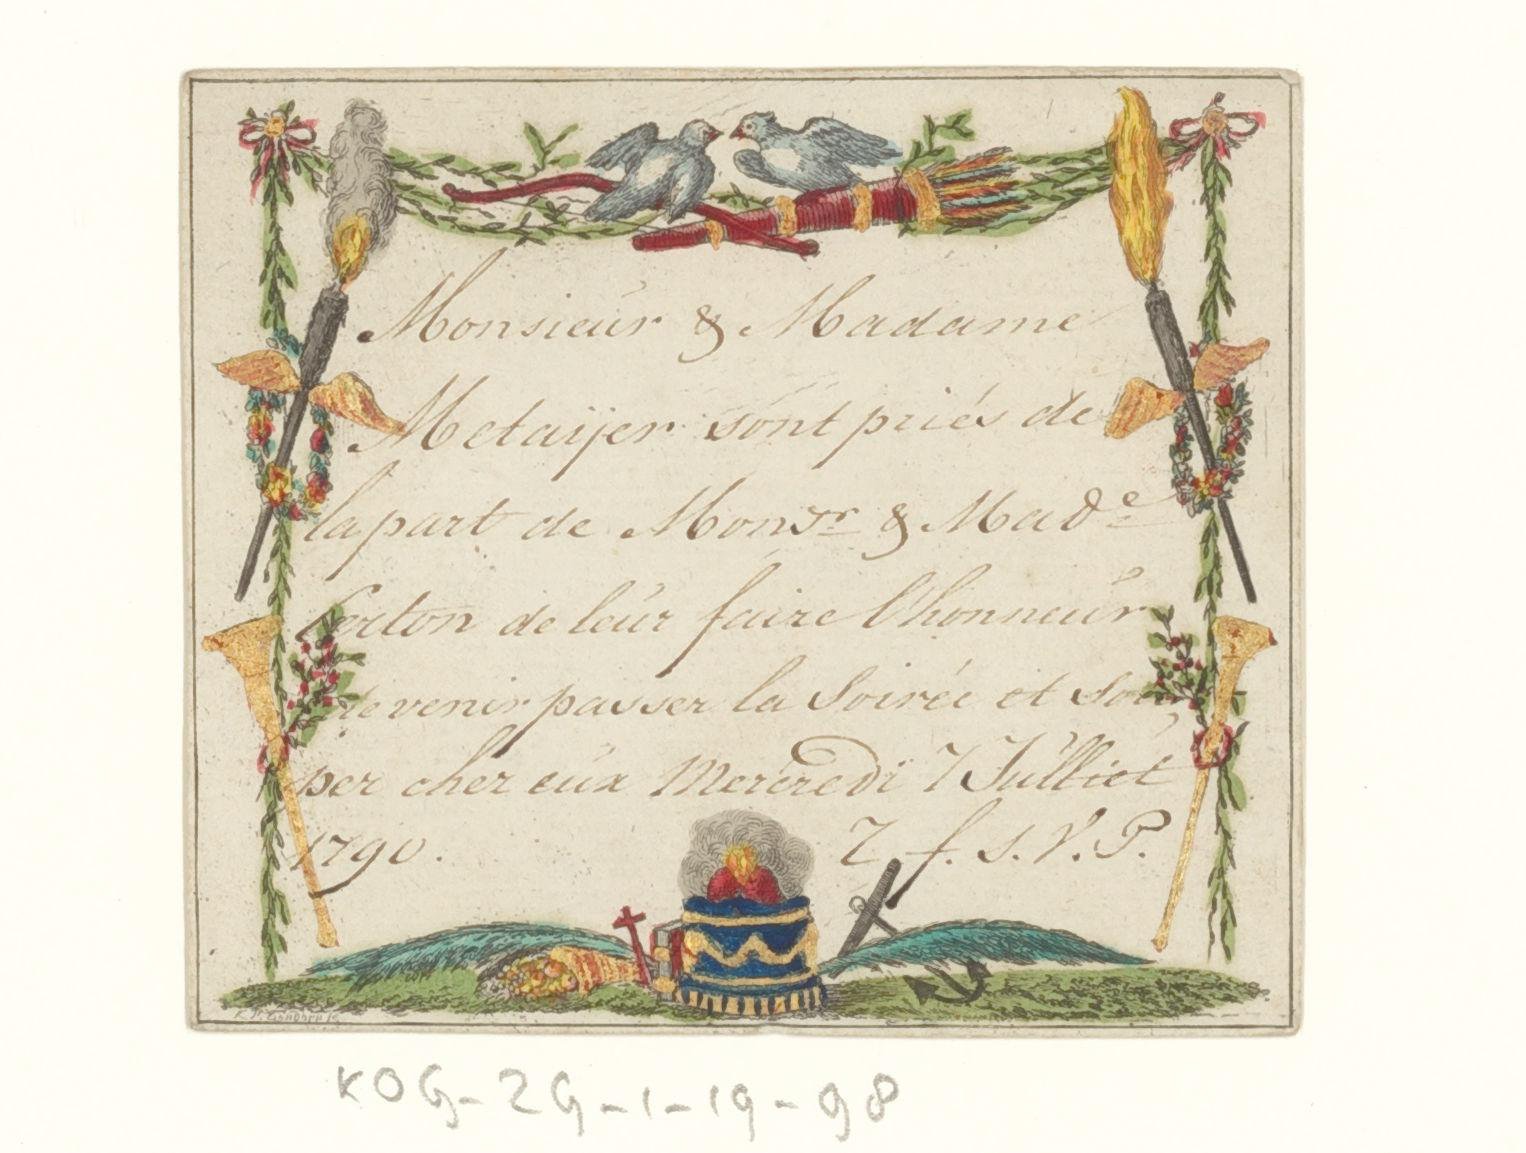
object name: print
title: Uitnodiging van Mons.r en Mad.e Certon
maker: catharina elisabeth metayer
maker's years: 1744-1800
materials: paint, paper, watercolor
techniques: etching, hand coloring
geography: netherlands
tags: goldsmith, louis metayer phzn., catharina elisabeth metayer, antoinette bernard, letter, envelope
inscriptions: collector's mark, collector's mark: Lugt 1641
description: Kaartje met een handgeschreven uitnodiging en RSVP aan dhr en mevr. Metayer namens Mad.e la veuve Vlacq (Catharina Elisabeth Metayer) en dhr. Henri Abraham Certon voor een soirée en souper bij hen op 7 juli 1790. Onderdeel van een groep van bruilofts- en invitatiekaartjes van de families Bernard en Metayer. Onderwerpsrubrieken binnen de Atlas Zeden en Gewoonten: Des Menschen Begin, Midden en Einde. Bruiloft en huwelijk.